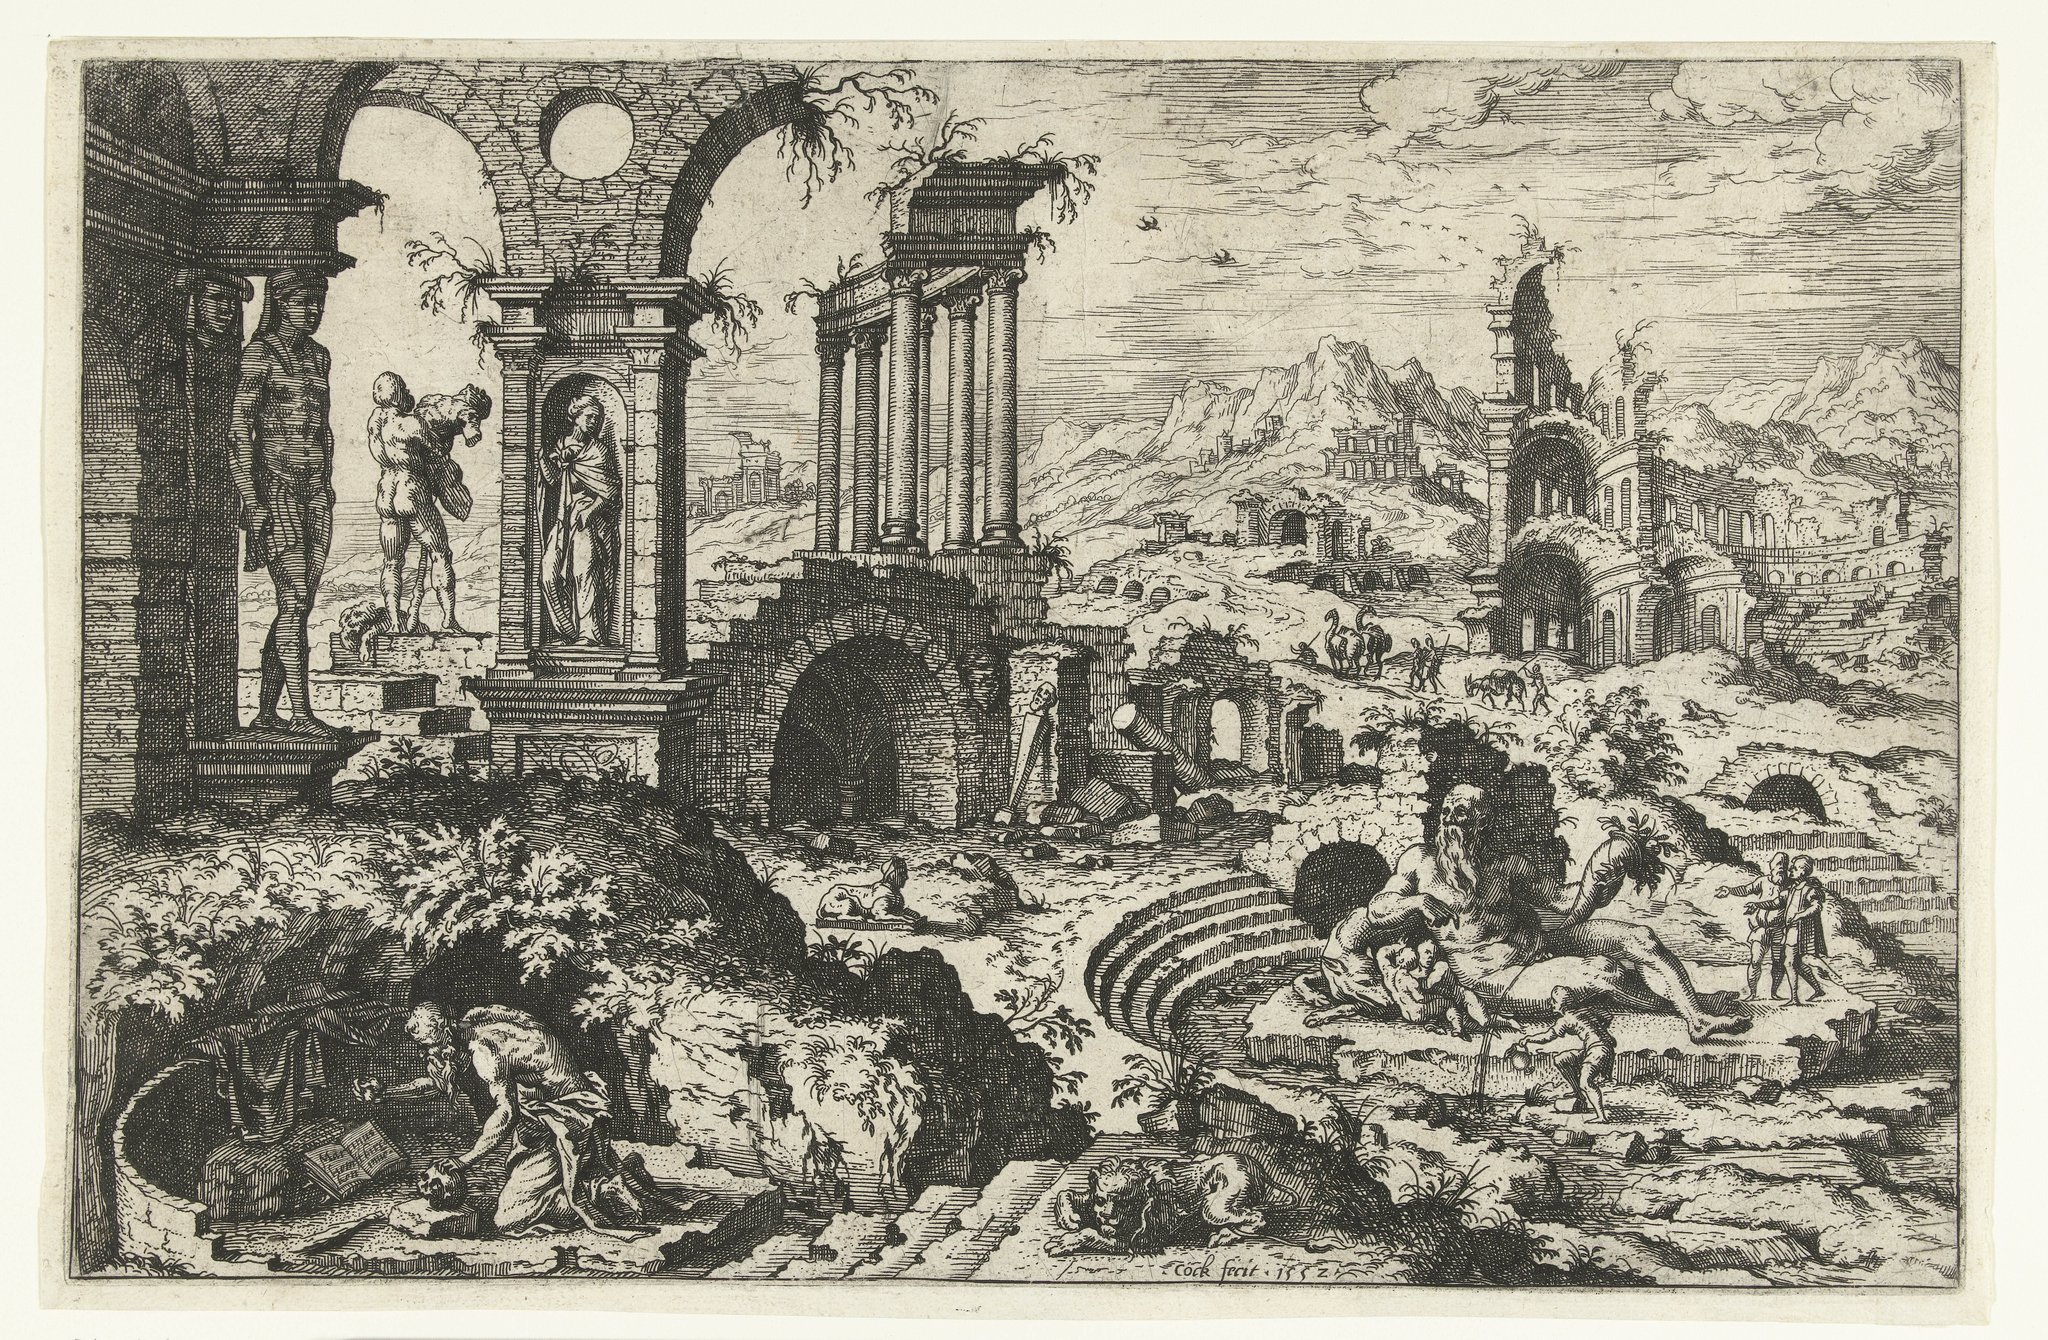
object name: print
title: Ruïnelandschap met de boetvaardige Hieronymus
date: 1552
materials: paper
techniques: etching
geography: antwerp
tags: st. jerome as penitent in the desert, half naked, kneeling before a crucifix and holding a stone in his hand to beat his breast; a skull (and other 'vanitas' symbols), sometimes a scorpion and a snake beside him, landscape with ruins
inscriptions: collector's mark: Lugt 2228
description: In een landschap met resten van Romeinse ruïnes knielt de heilige Hieronymus op de grond en slaat zichzelf met een steen. Zijn mantel en kardinaalshoed liggen op een stenen muur. Hij steunt op een schedel. De leeuw zijn symbool ligt boven aan een lage trap en likt zijn poten.